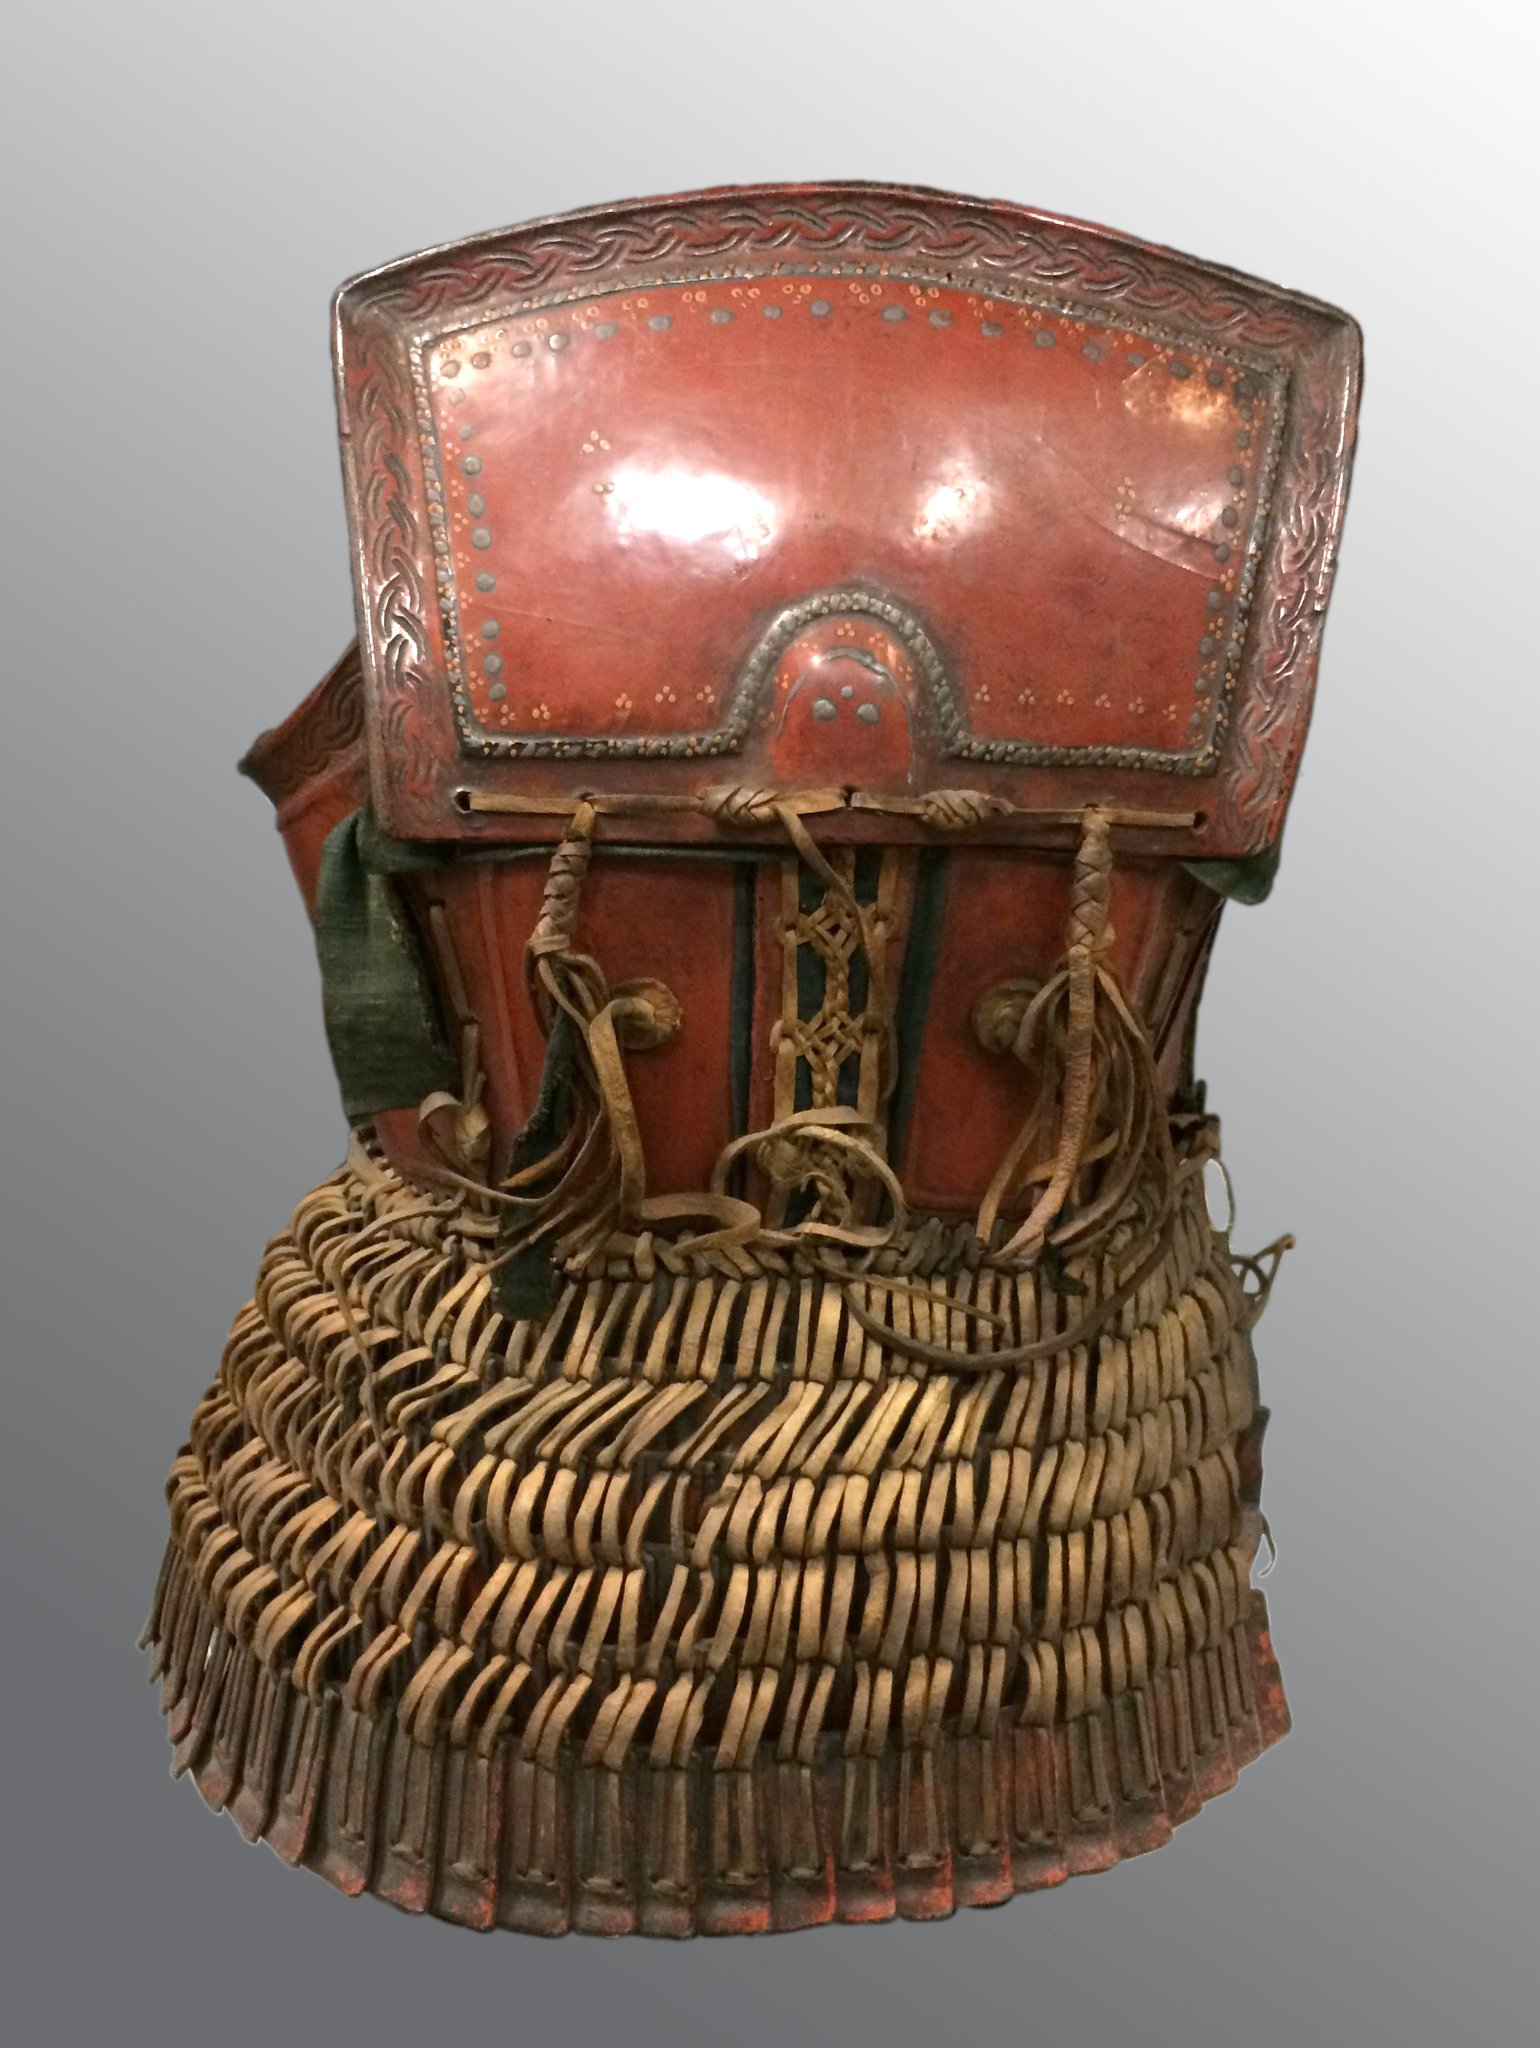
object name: cuirass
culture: yi or nuosu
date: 1701-1900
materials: lacquer, leather, wood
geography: china